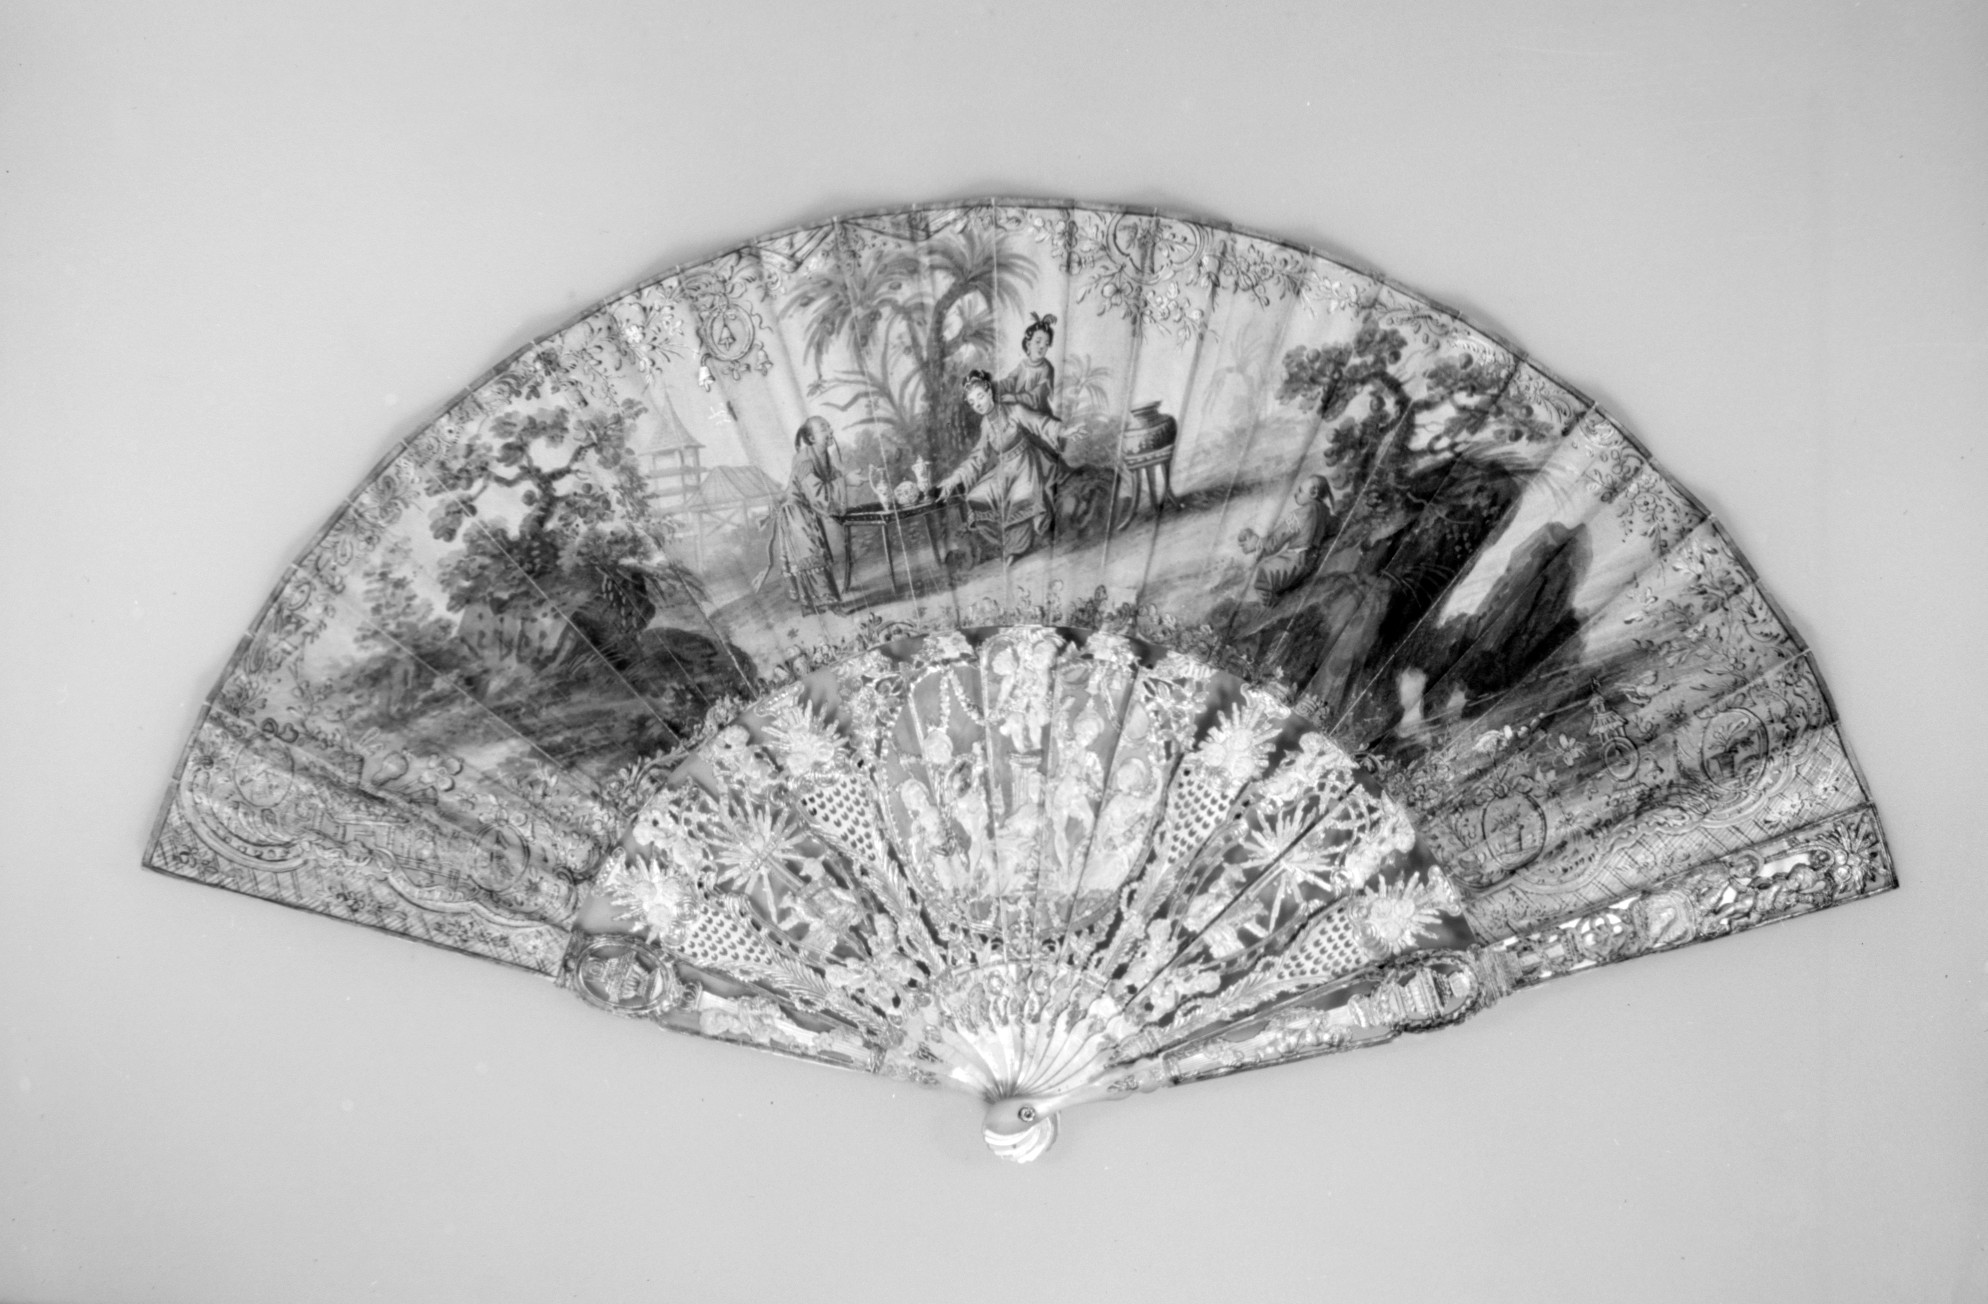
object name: fan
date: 1701-1800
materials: ivory, mother of pearl, paper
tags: chinoiserie,men,women,tea drinking